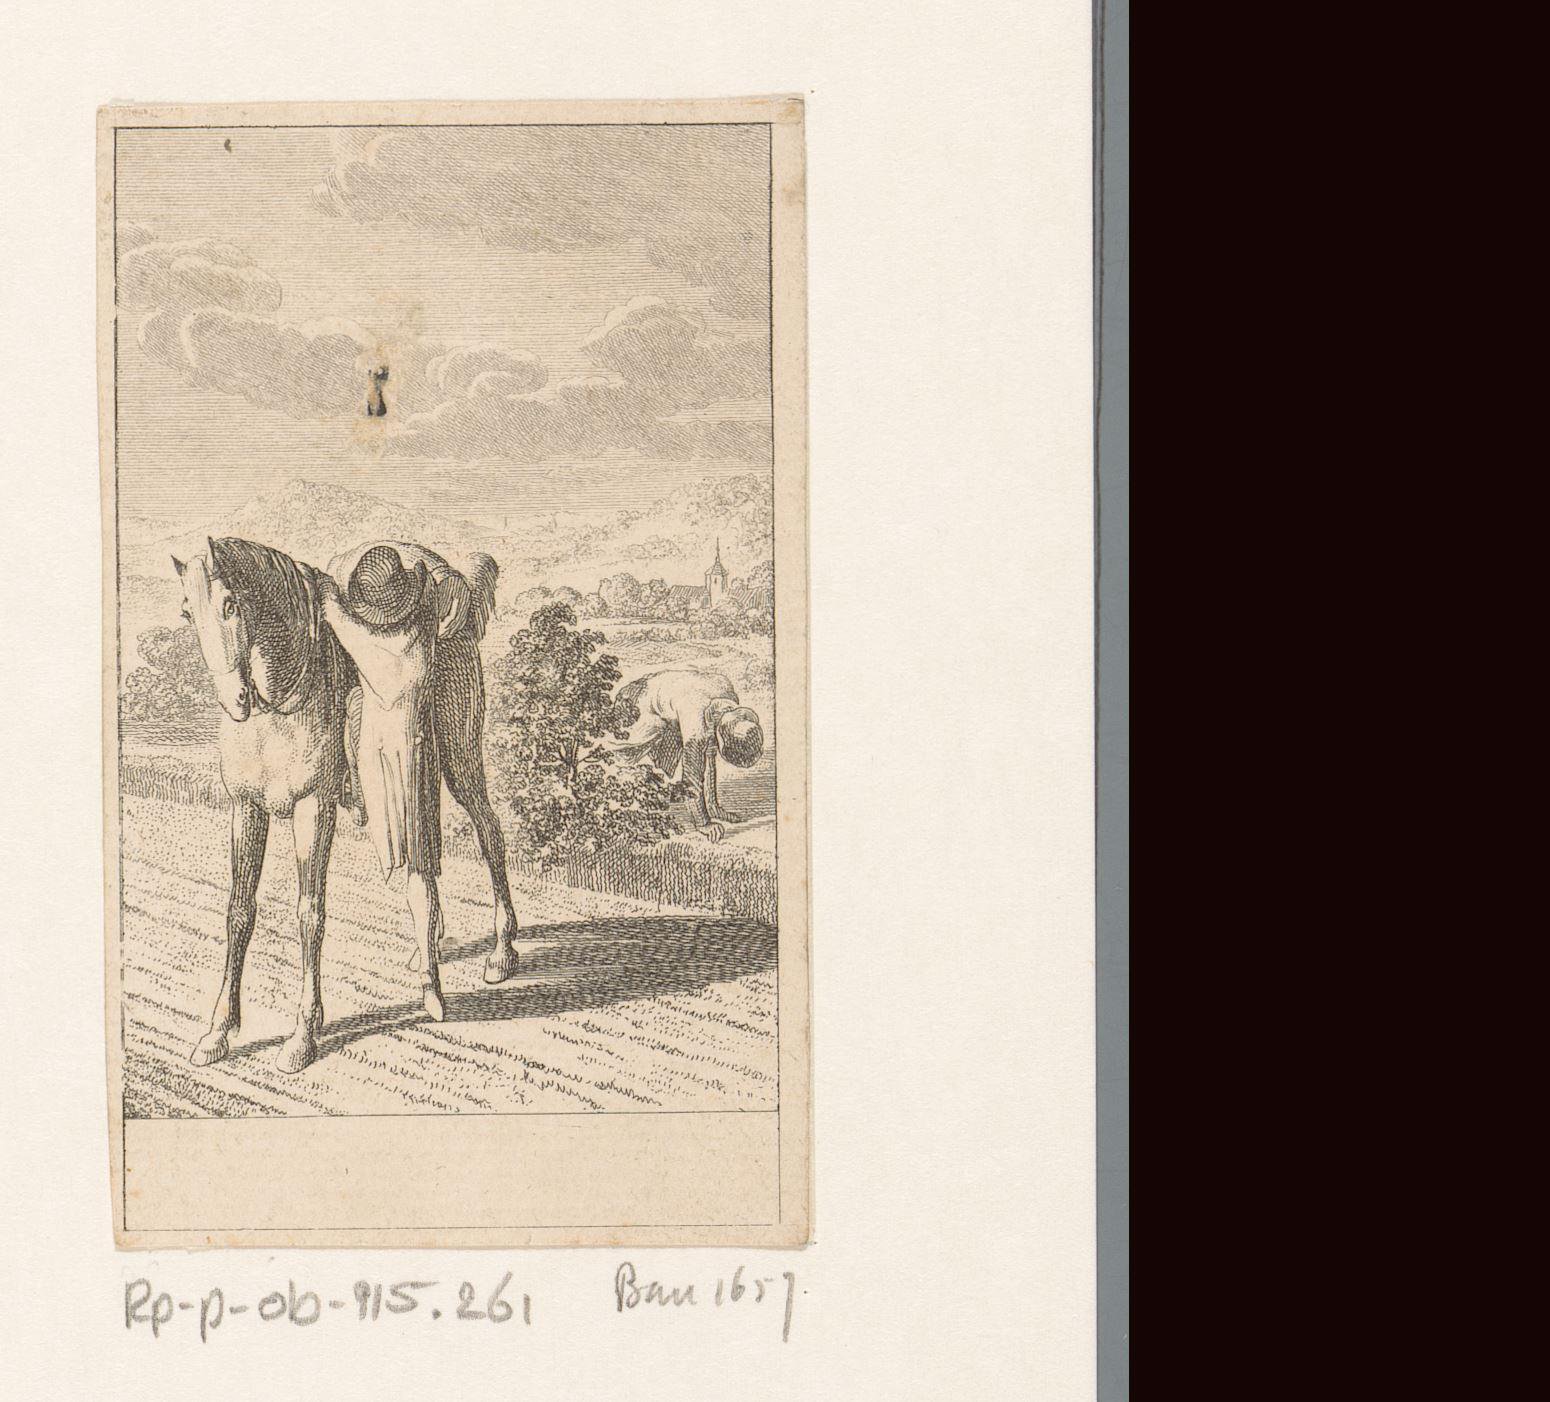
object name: print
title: James Brown bestijgt zijn paard terwijl een rover zich verstopt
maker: daniel nikolaus chodowiecki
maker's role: draughtsman, print maker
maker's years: 1726-1801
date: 1793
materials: paper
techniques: etching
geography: berlin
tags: history, robber, horse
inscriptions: collector's mark: Lugt 2228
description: Vervaardigd als één van twaalf voorstellingen uit de oudste, middelste en nieuwste geschiedenis. Latere staat gebruikt voor: Genealogischen Calender zur angenehmen und nützlichen Unterhaltung auf das Jahr 1794. Berlijn: Königl. Akademie der Wissenschaften, [1793].